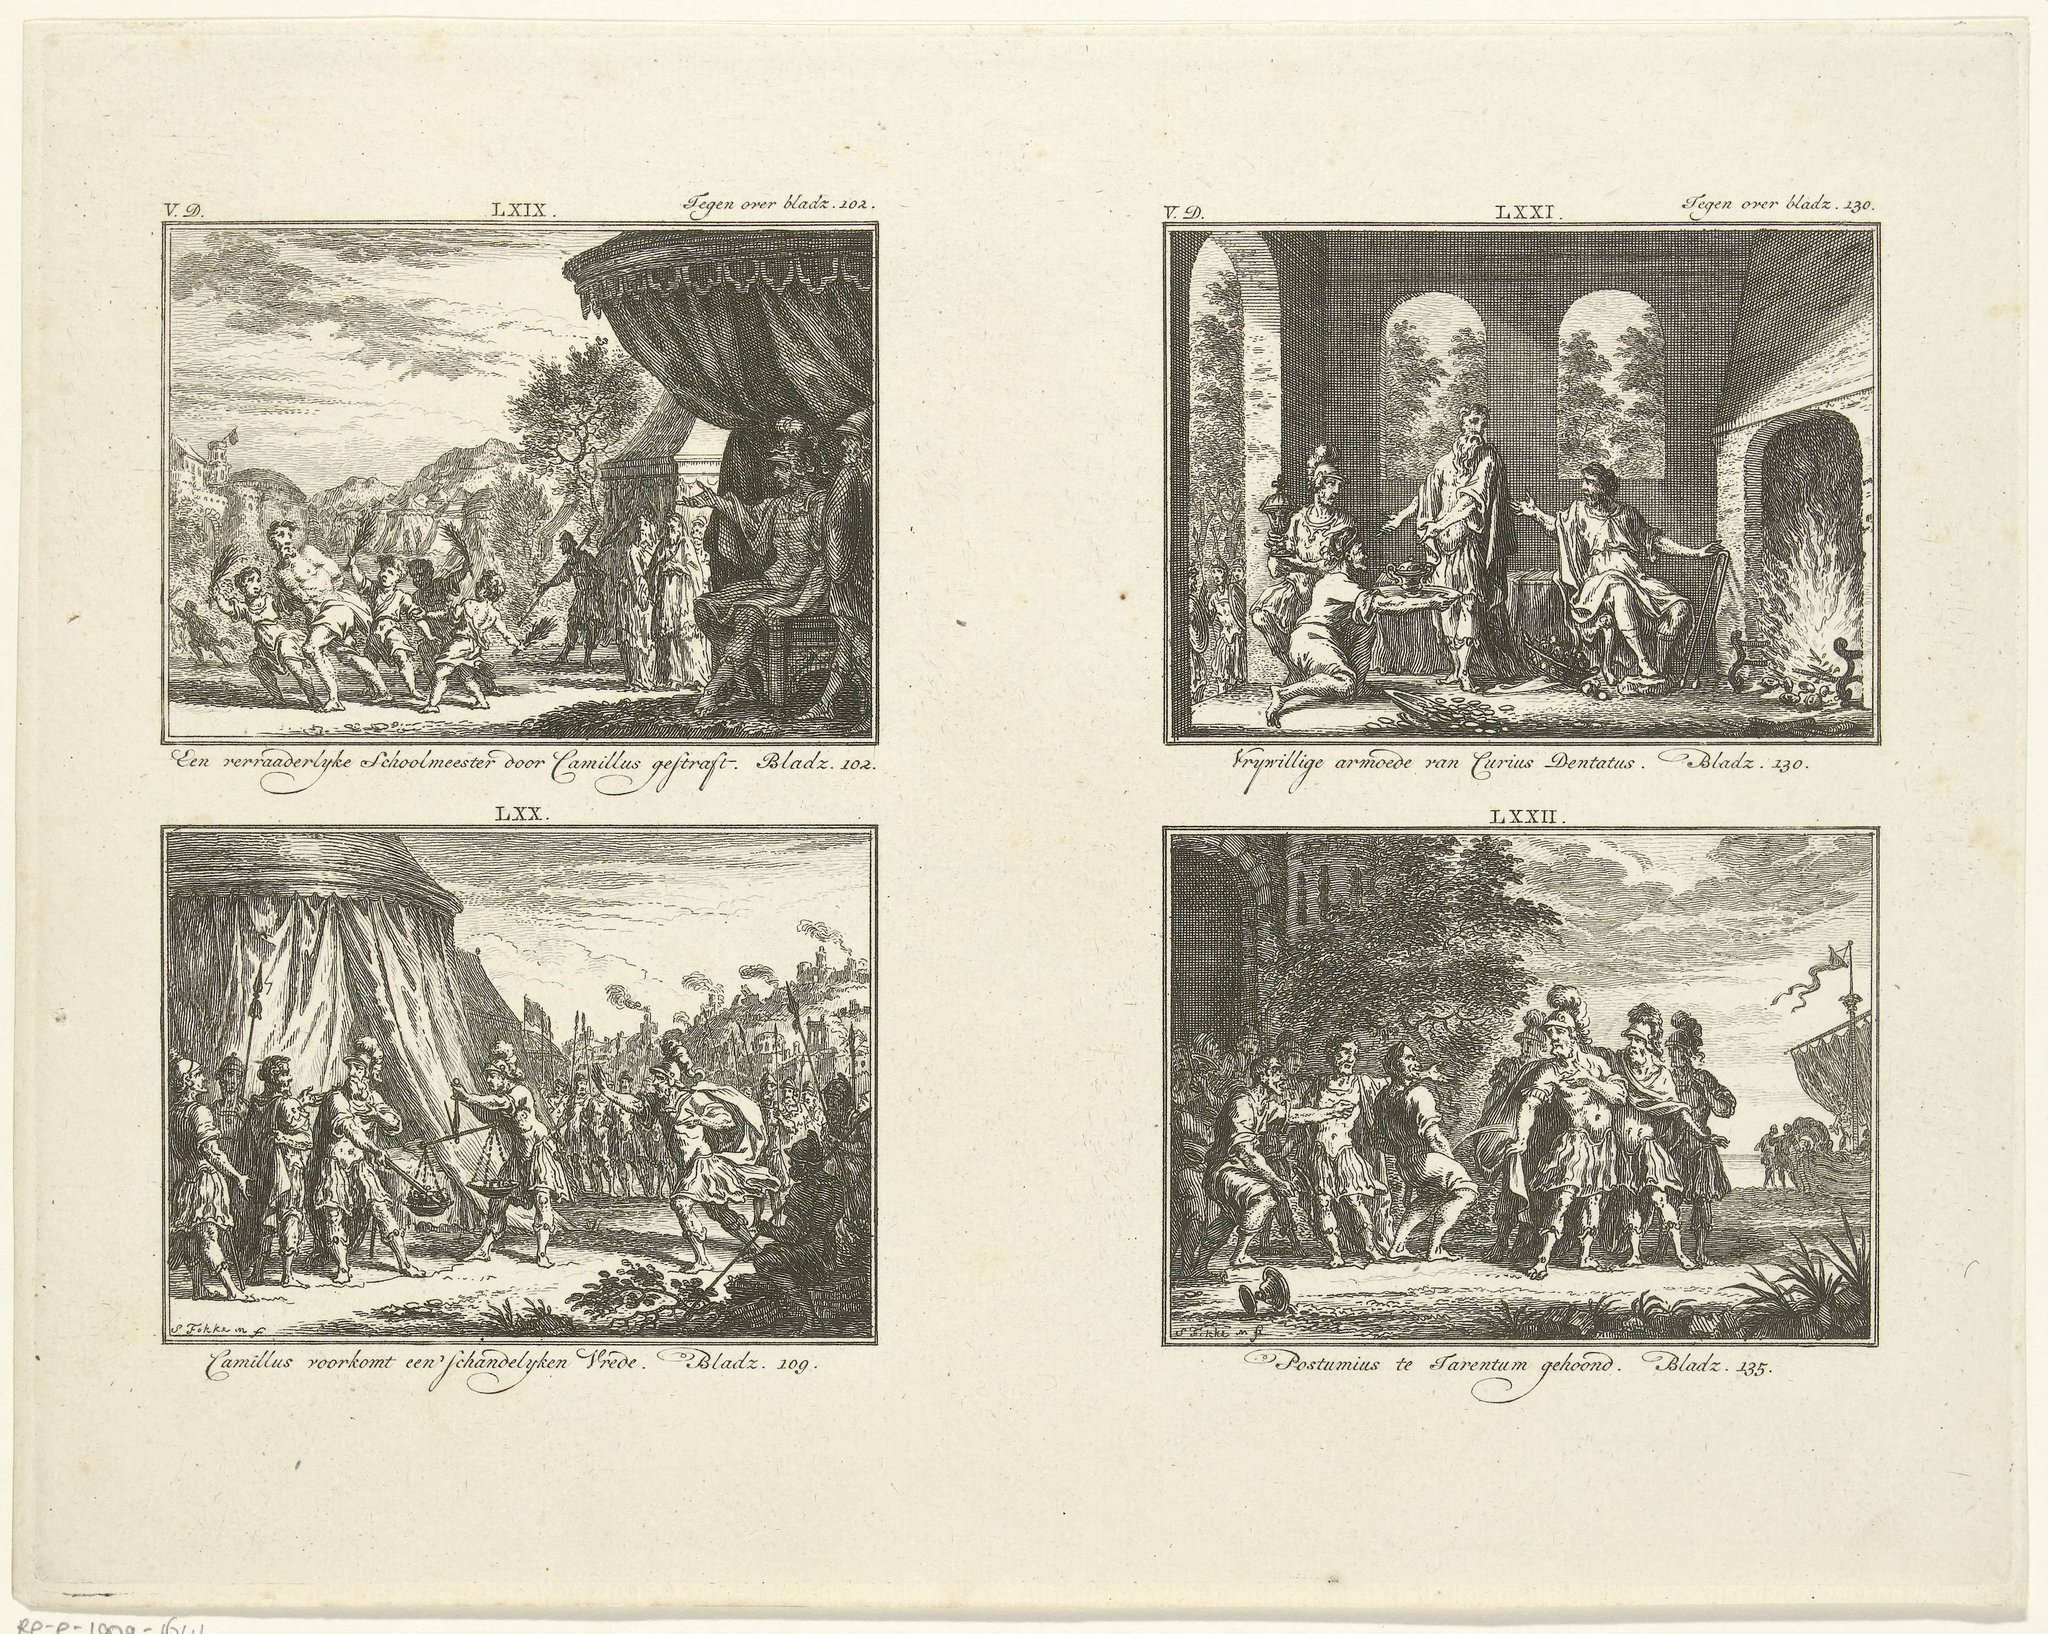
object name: print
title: Illustraties uit de klassieke geschiedenis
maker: simon fokke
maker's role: draughtsman, print maker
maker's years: 1712-1784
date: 1722-1784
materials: paper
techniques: etching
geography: amsterdam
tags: (story of) a. postumius tubertus - suffering, misfortune of person from classical history, manius curius dentatus, while cooking a simple meal at his hearth, refuses the gifts of the samnites, (story of) marcus furius camillus, marcus furius camillus has the schoolmaster of falerii chastised by his pupils: he is stripped and the children drive him back to their city with sticks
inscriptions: collector's mark: Lugt 2228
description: Vier voorstellingen uit de klassieke geschiedenis van één plaat, genummerd van LXIX tot en met LXXII en alle voorzien van een onderschrift. Linksboven: Schoolmeester door Camillus gestraft. Linksonder: Camillus voorkomt een schandelijke vrede. Rechtsboven: Curius Dentatus leeft vrijwillig in armoede. Rechtsonder: Postumius te Tarentum bespot. Voorstellingen LXIX en LXX rechtsboven gemerkt: Tegen over bladz. 102. Voorstellingen LXXI en LXXII rechtsboven gemerkt: Tegen over bladz. 130.